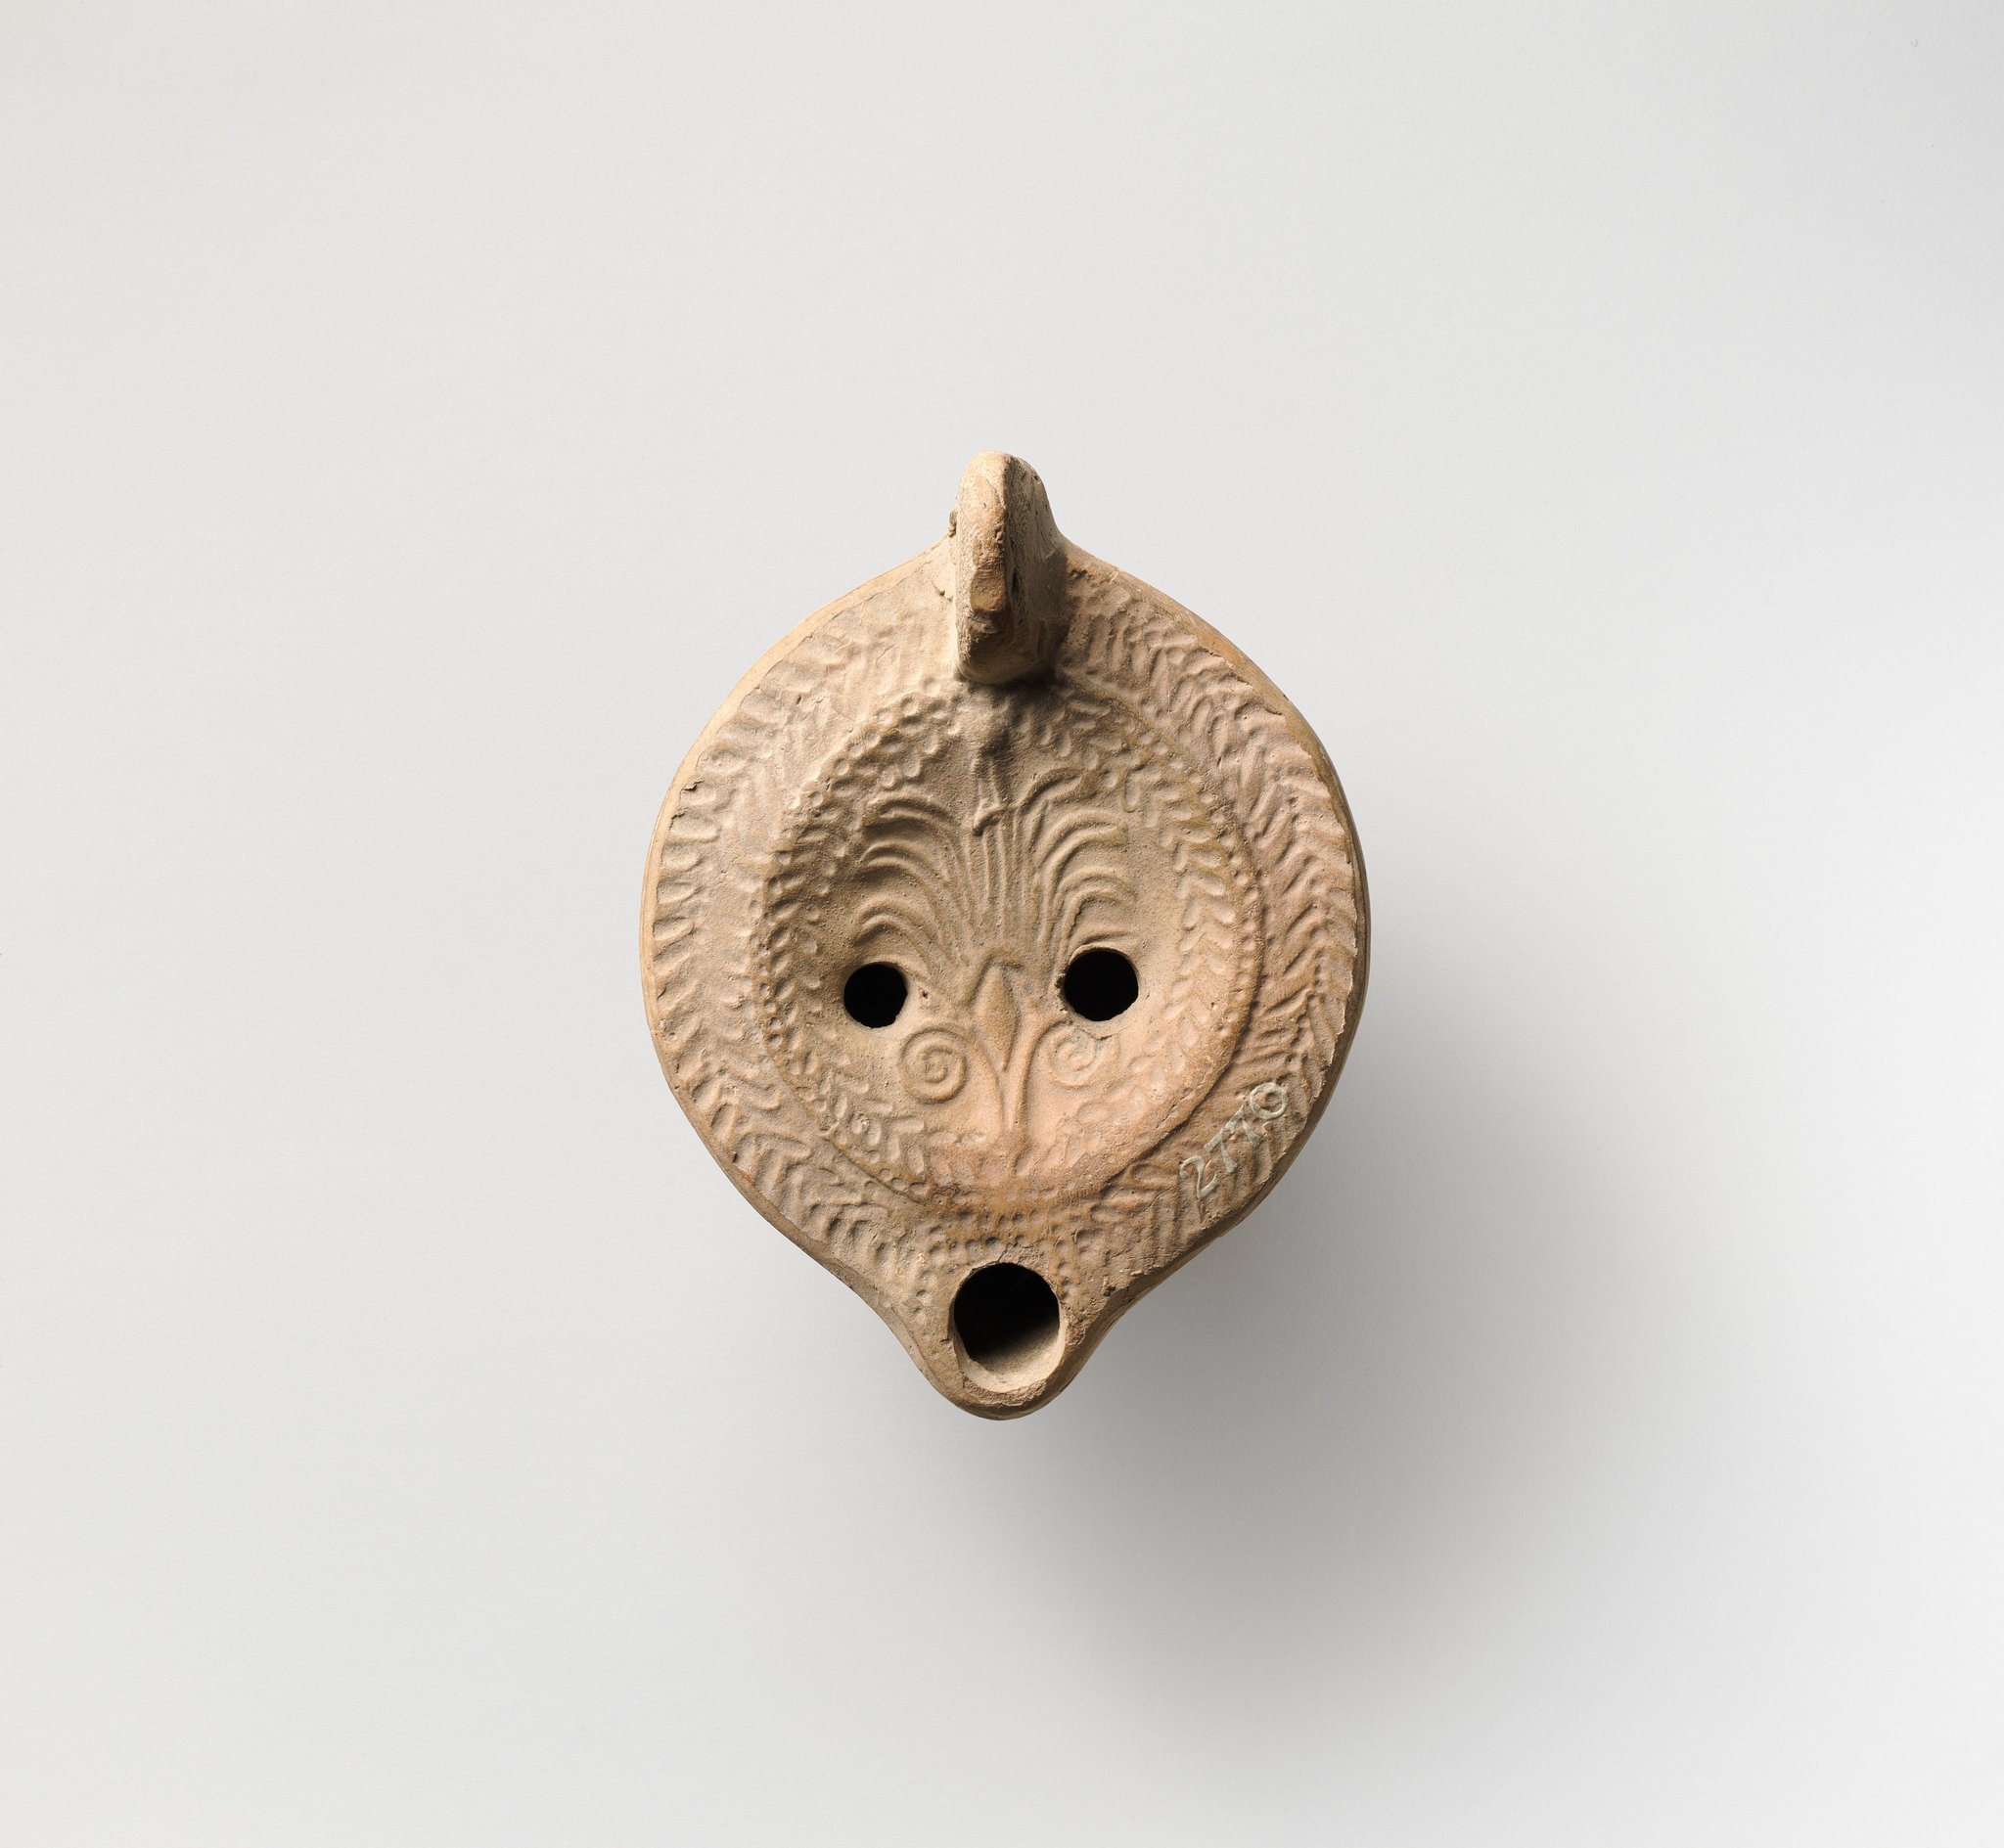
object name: lamp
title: Terracotta oil lamp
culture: roman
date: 201-300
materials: terracotta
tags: palmettes